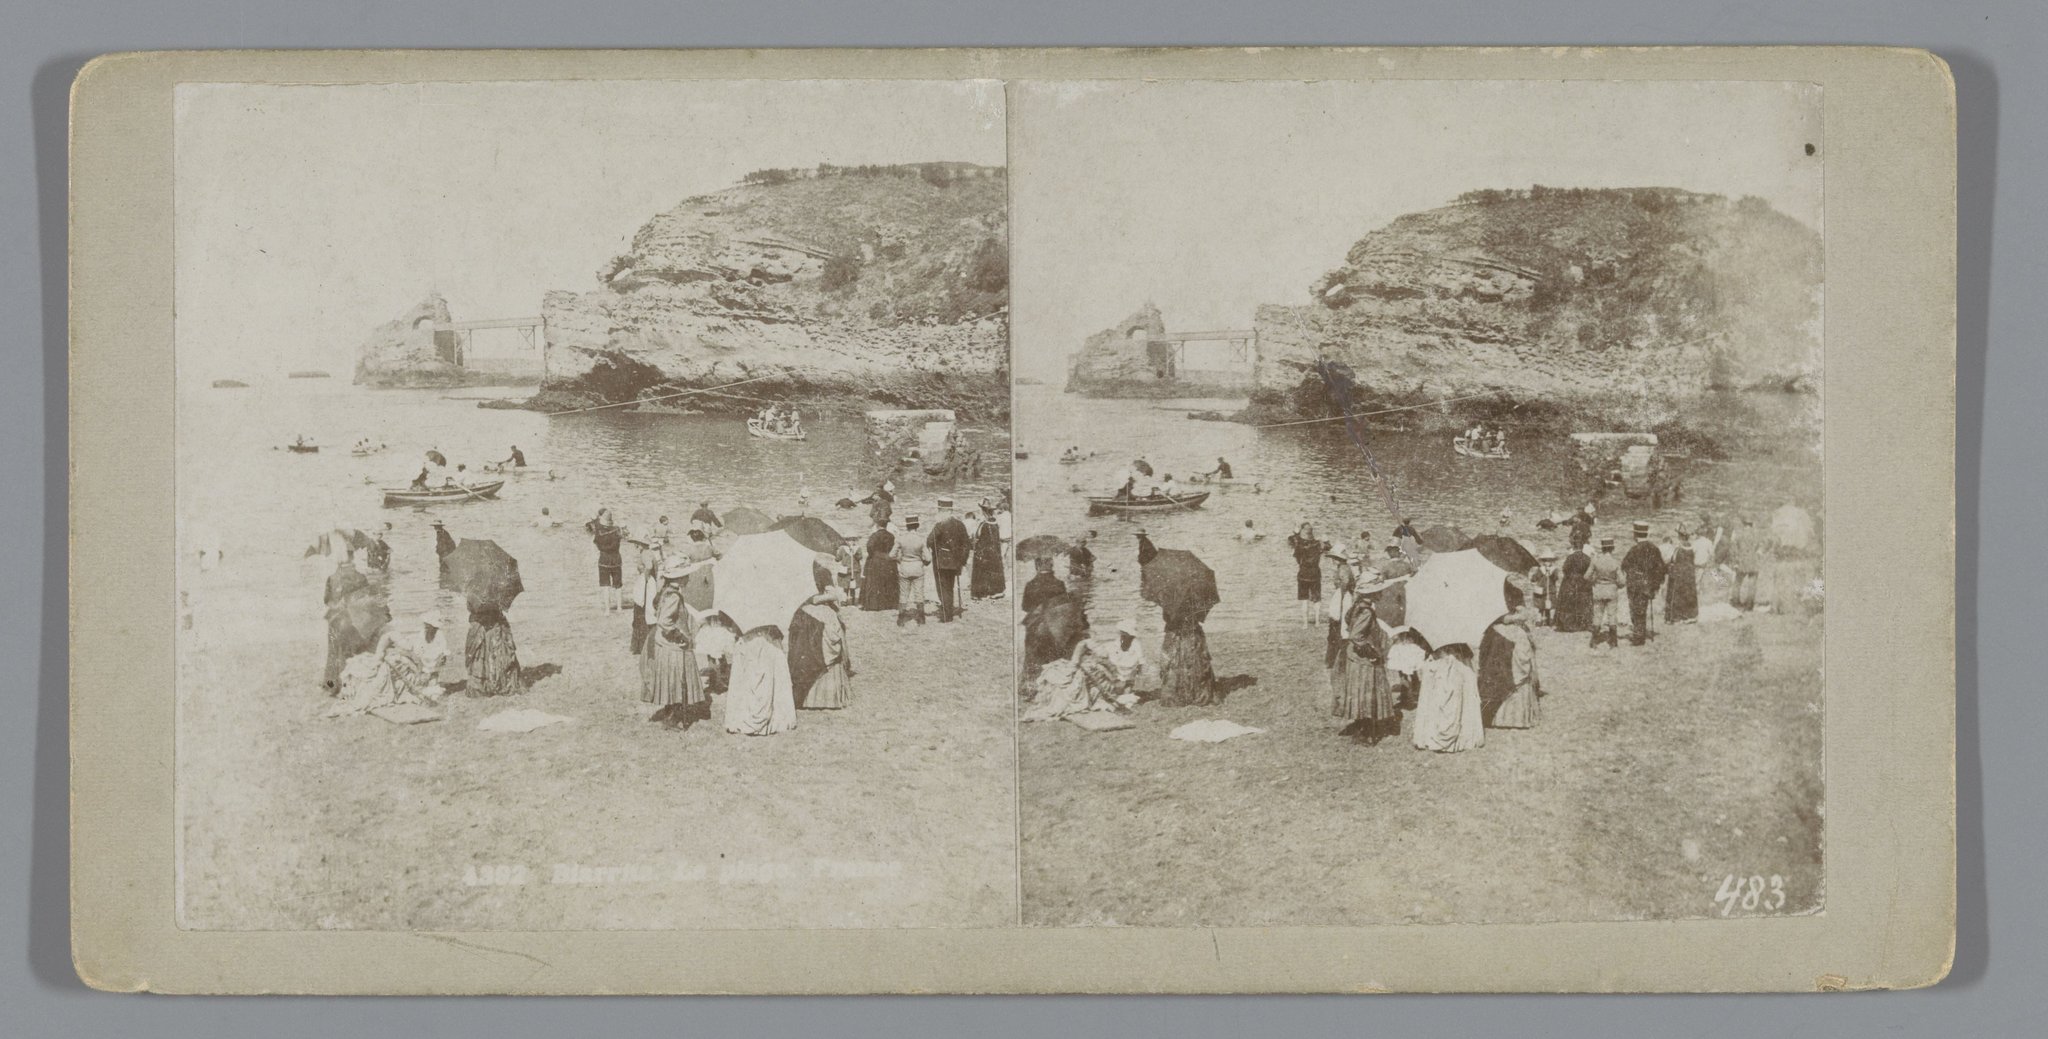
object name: stereograph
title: Gezicht op het strand van Biarritz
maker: Anonymous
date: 1890-1905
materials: cardboard, photographic support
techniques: gelatin silver print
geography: biarritz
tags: beach (as place of recreation)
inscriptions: number: ‘4392.’, number: ‘483’